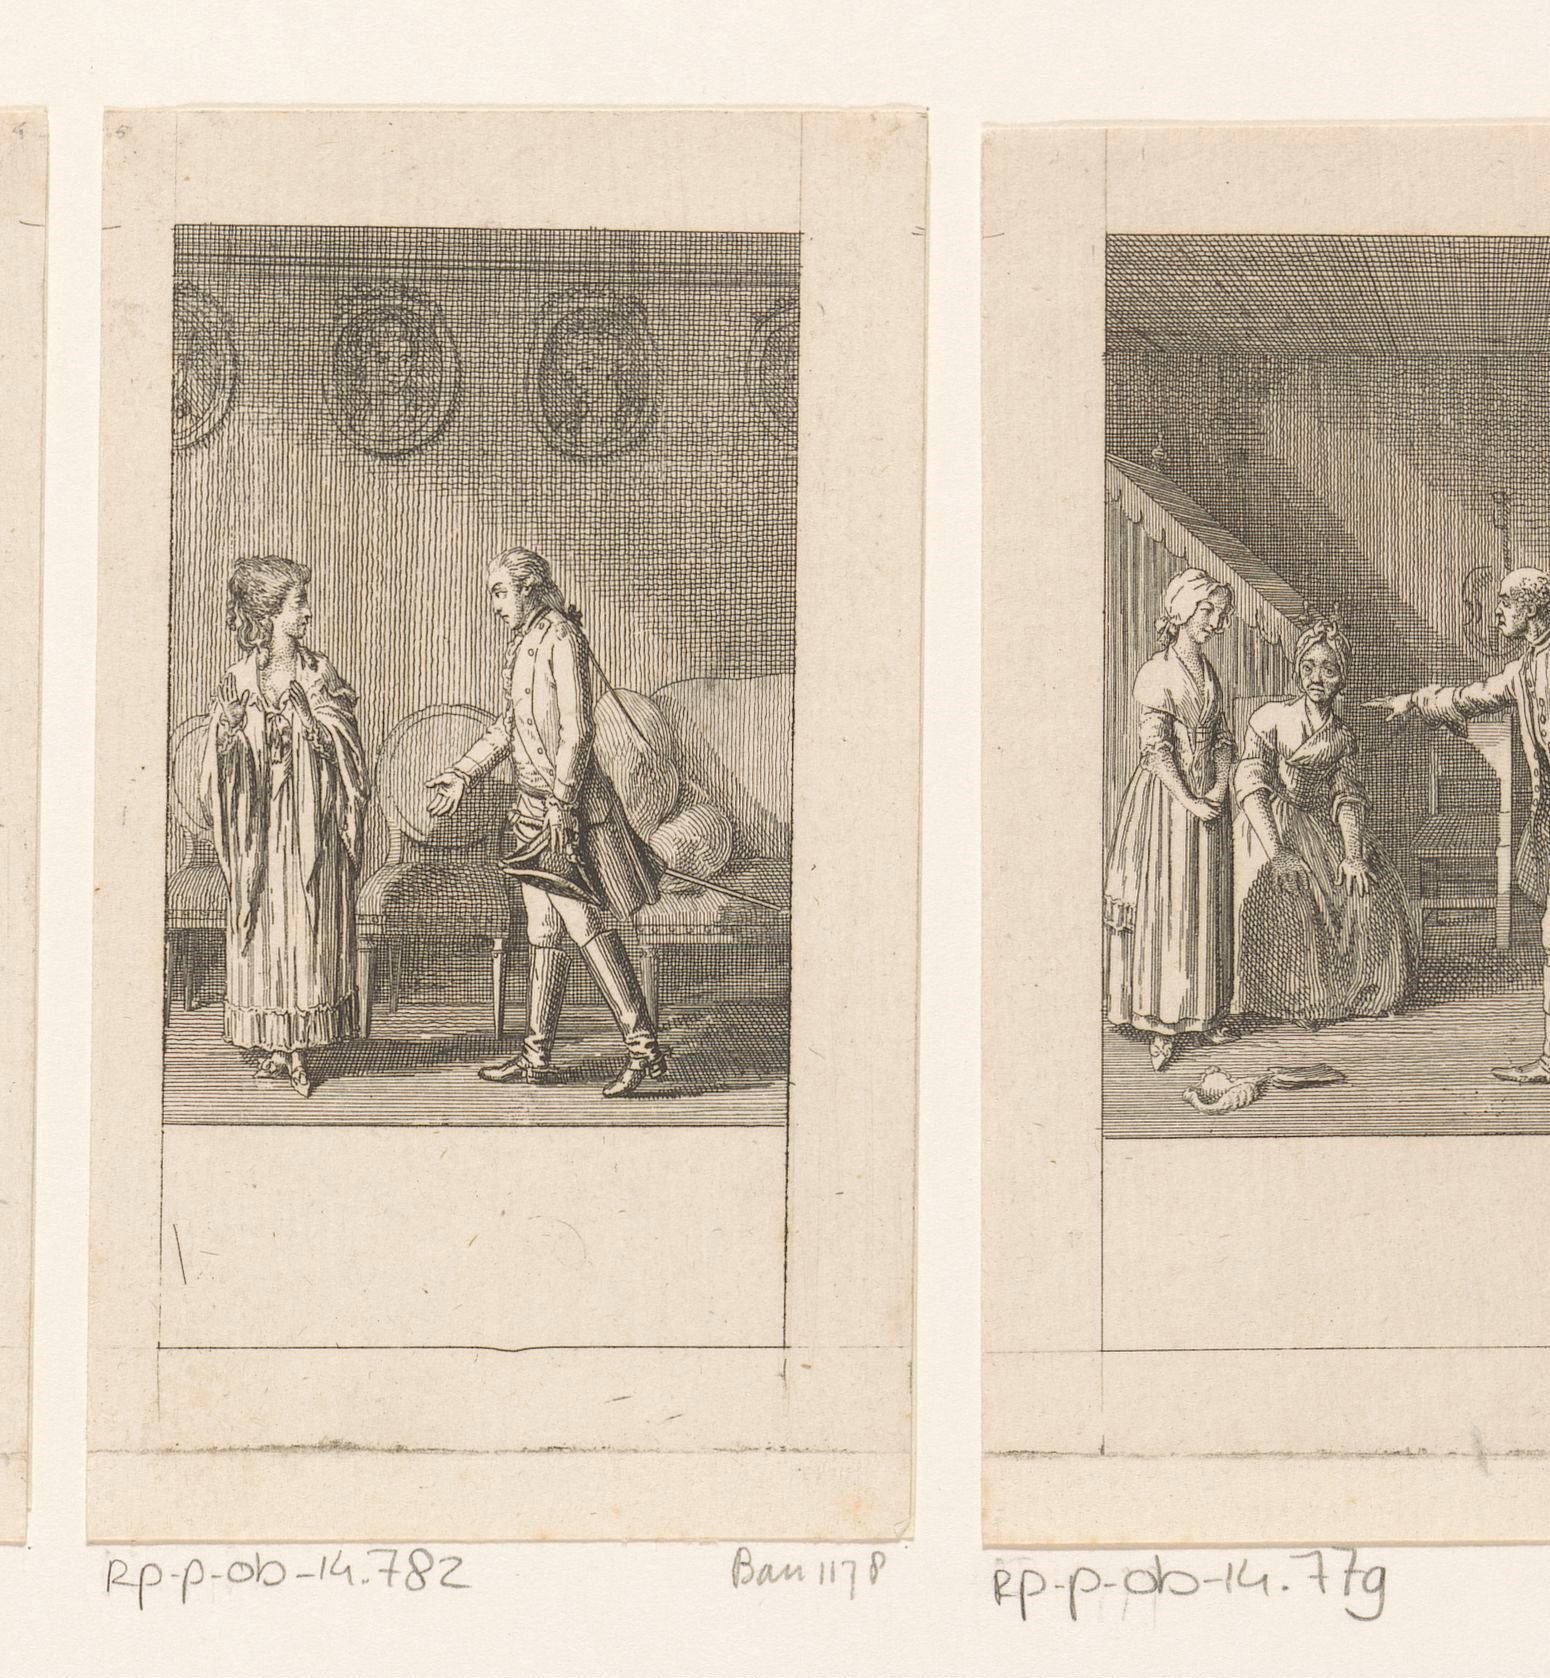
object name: print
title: Ferdinand vertelt Lady Milford dat hij een burgermeisje lief heeft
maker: daniel nikolaus chodowiecki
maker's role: draughtsman, print maker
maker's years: 1726-1801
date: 1785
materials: paper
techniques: etching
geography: berlin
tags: literature, ornament ~ medallion (+ framing decorations), conversation, dialogue; conversation piece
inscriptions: collector's mark: Lugt 2228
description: Vervaardigd voor Friedrich von Schiller 'Kabale und Liebe'. Latere staat gebruikt voor: Königl. Grossbrit. Genealogischer Kalender auf das Jahr 1786. Lauenburg: J. G. Berenberg, 1785.